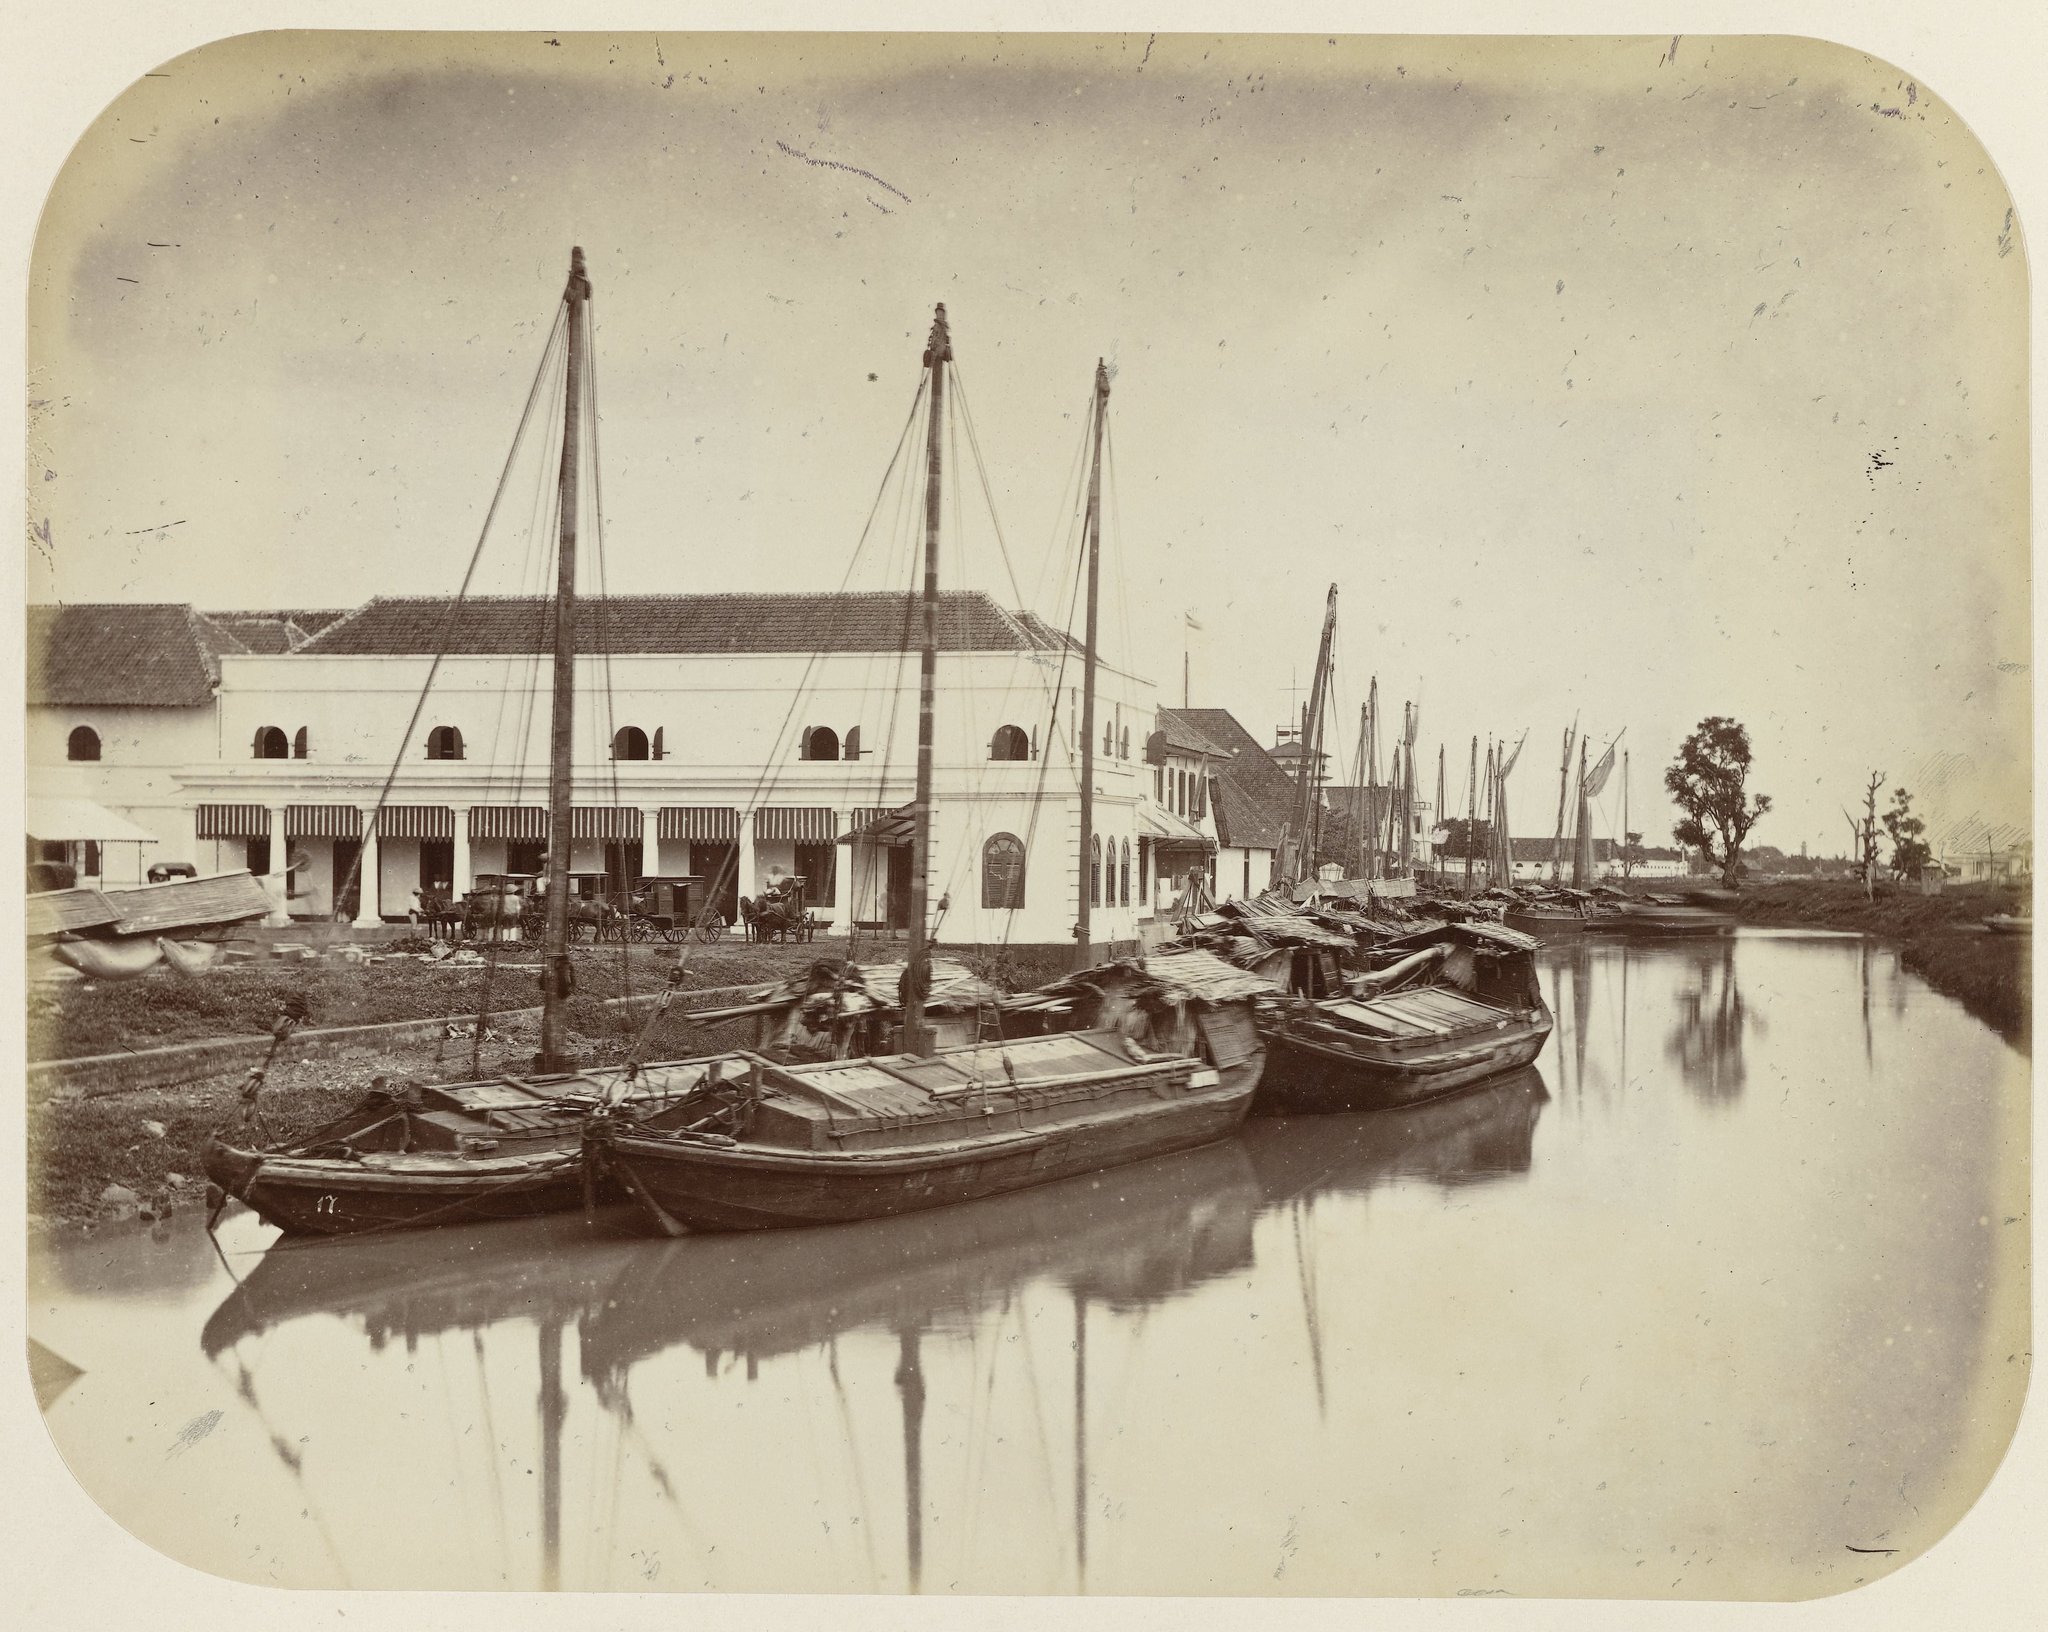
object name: photograph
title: Groote Boom aan het Havenkanaal te Batavia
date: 1863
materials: photographic support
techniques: albumen print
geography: batavia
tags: harbour, java, batavia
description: Gezicht op de Groote Boom aan het Havenkanaal te Batavia. Op de voorgrond aangemeerde schuiten. Ingeplakte foto in het fotoalbum getiteld: Gezichten van Java.